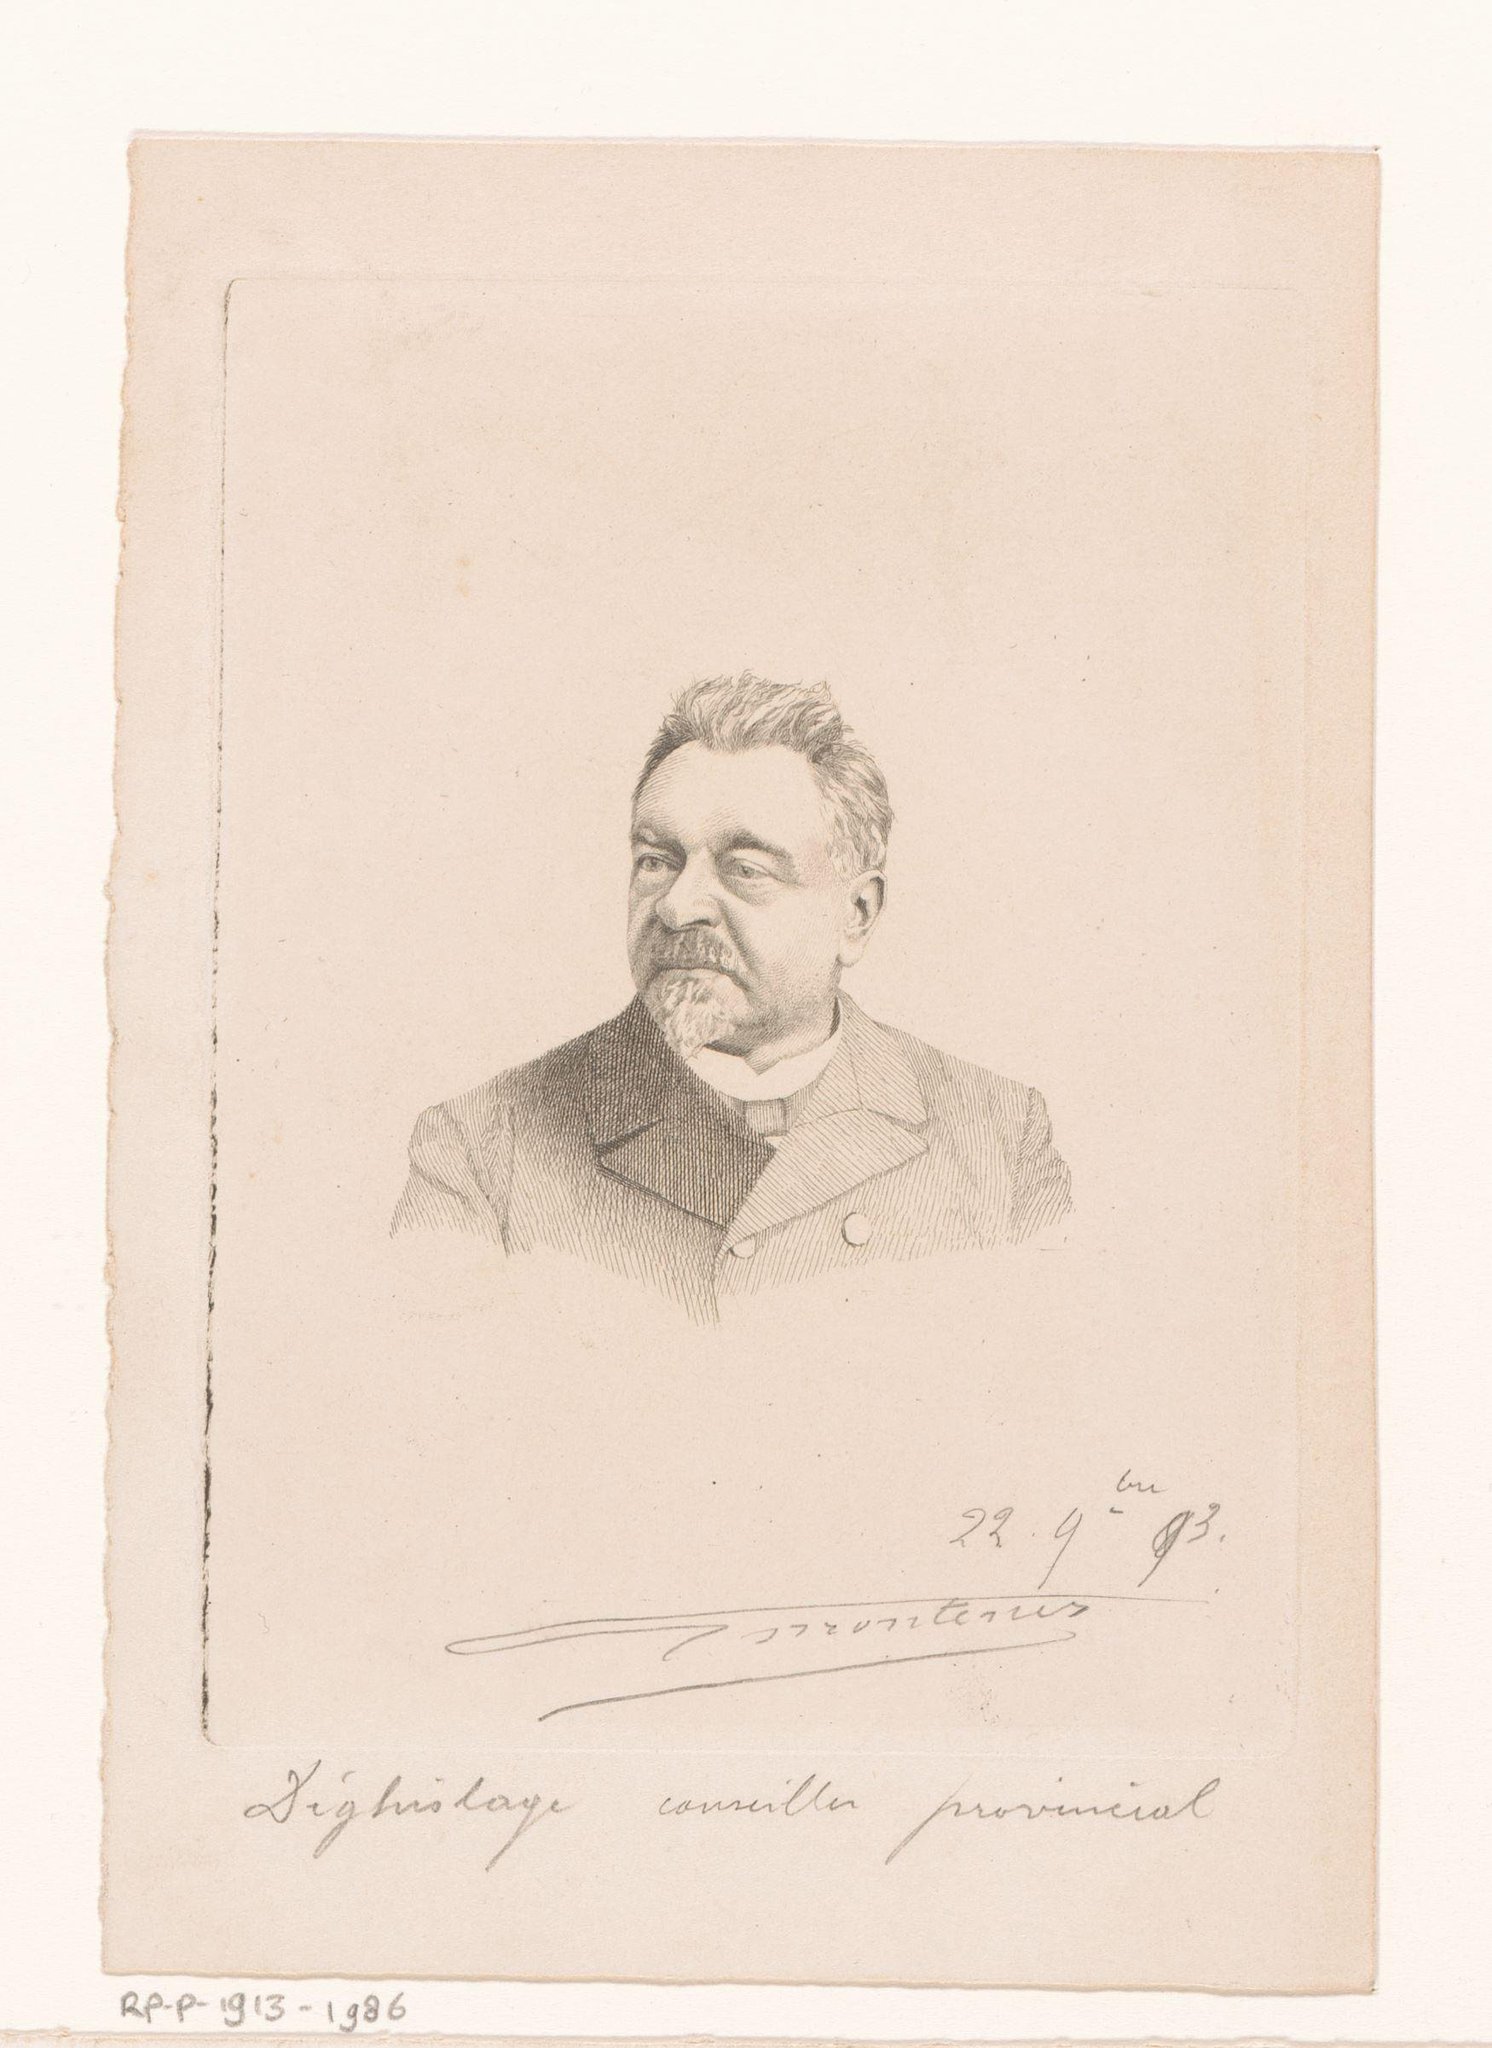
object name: print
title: Portret van een onbekende man, mogelijk Dighislage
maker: georges montenez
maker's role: print maker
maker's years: 1873-1930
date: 1893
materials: paper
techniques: etching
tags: adult man, historical persons, beard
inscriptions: collector's mark: Lugt 2228, inscription: ‘22 9 m 93; Dighislage conseiller provincial’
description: In de inventaris getiteld: Portret van Mr. Dighislage (?) Conseiller provincial.